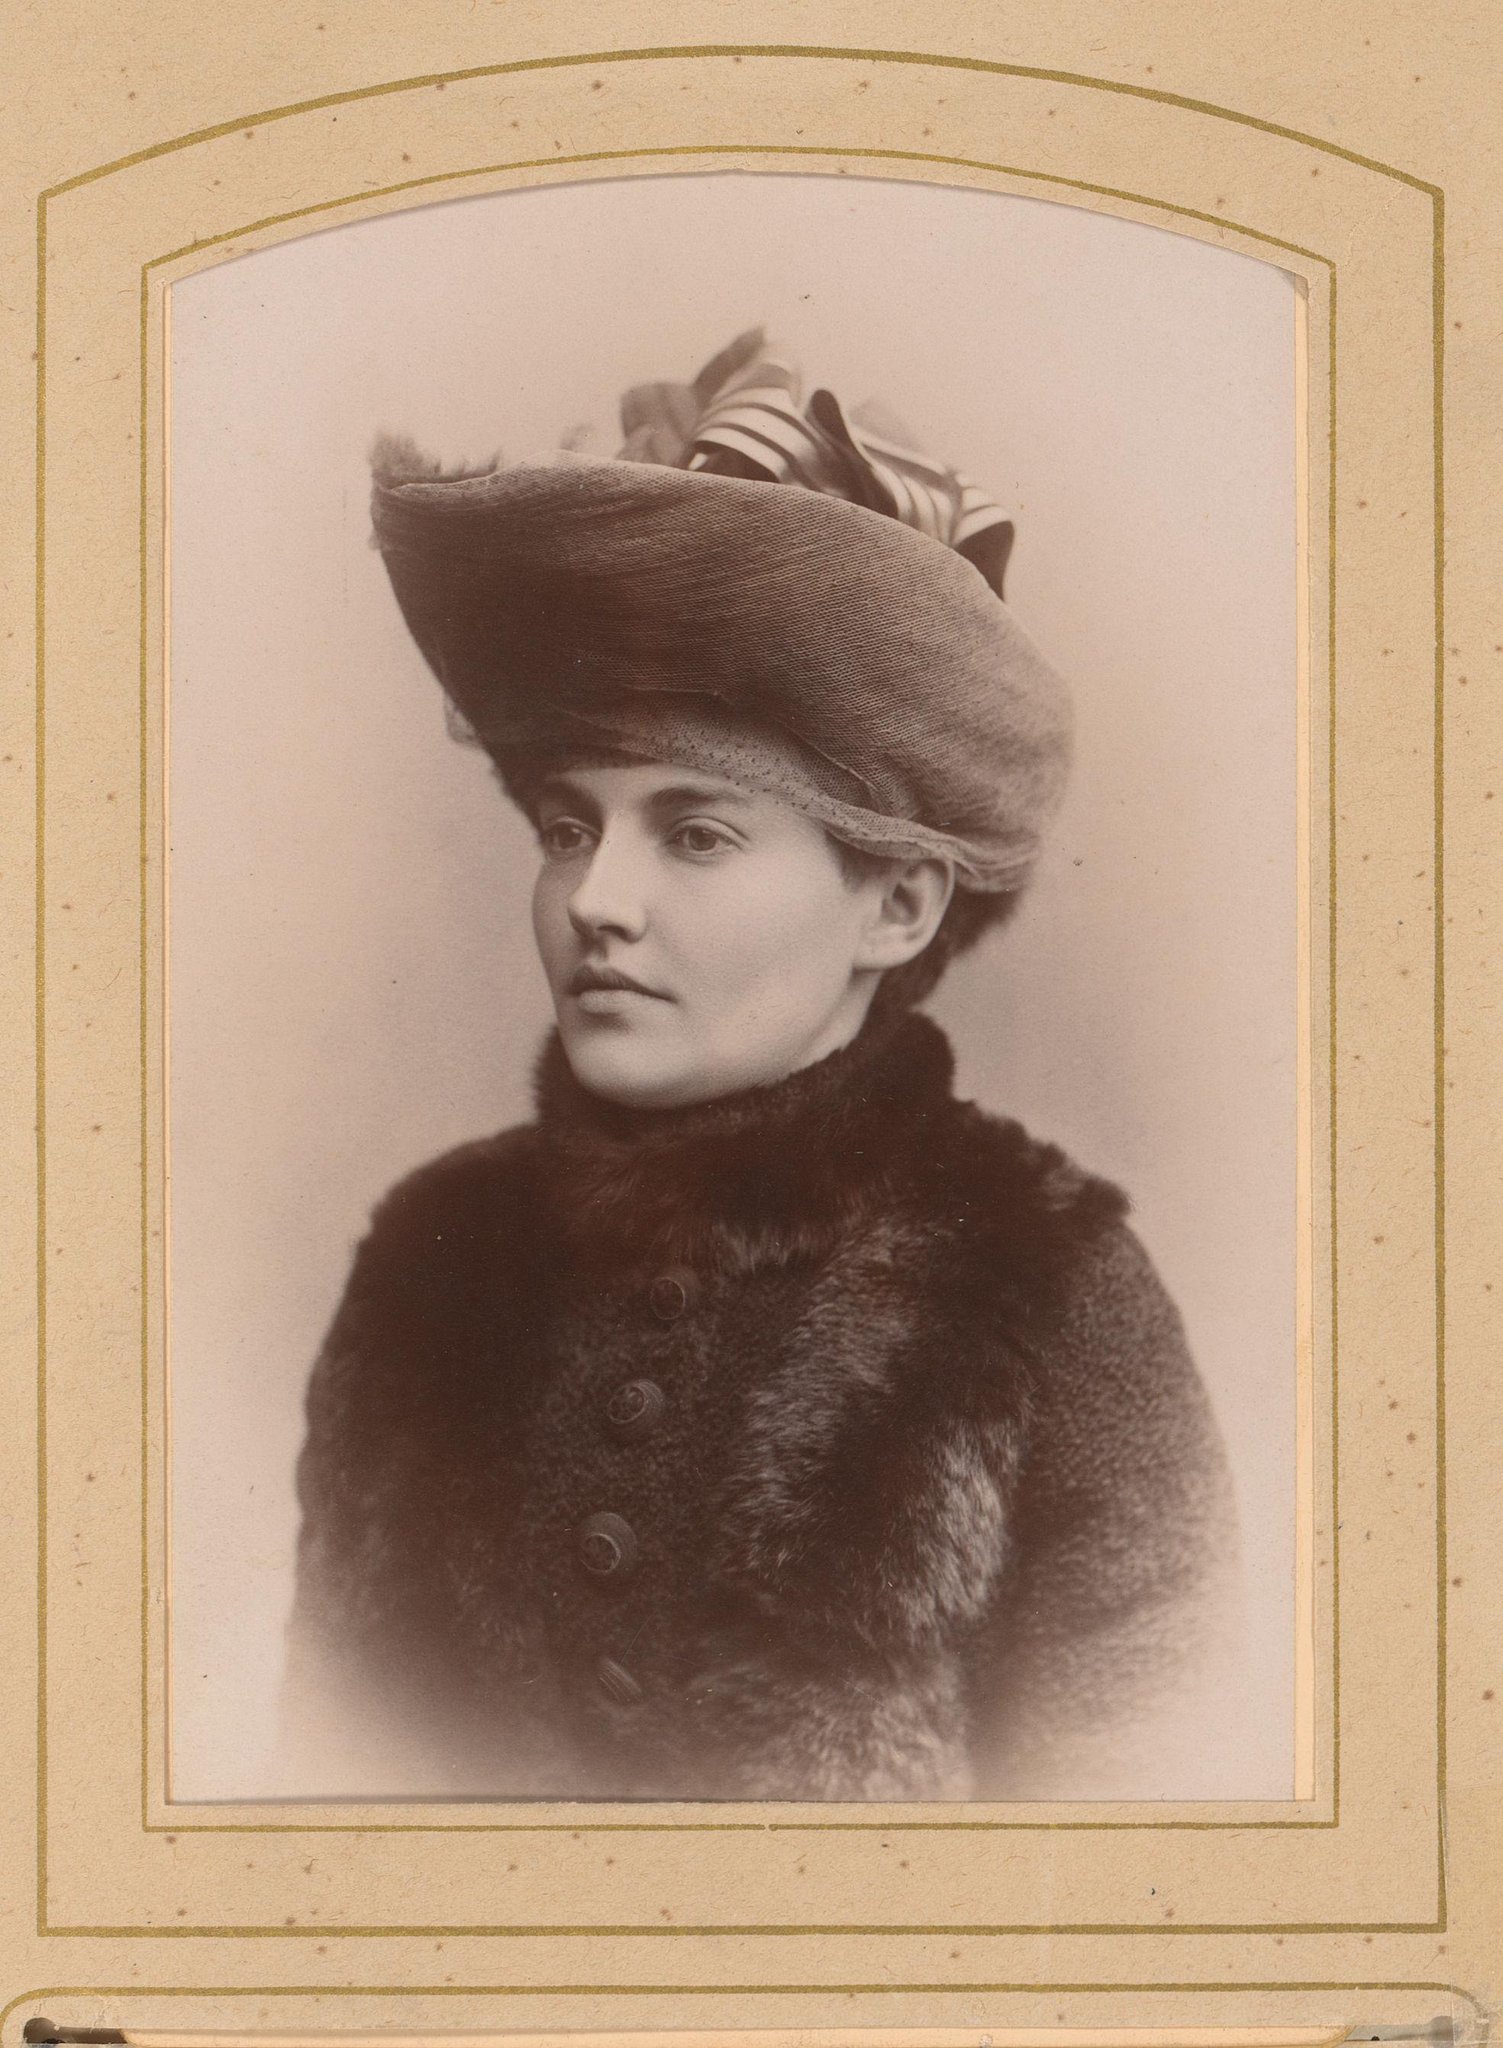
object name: album leaf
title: Portret van een vrouw in bontjas met hoed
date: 1860-1900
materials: cardboard, photographic support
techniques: albumen print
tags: historical persons - bb - woman, coat (+ fur used for clothes), coat: overcoat, head-gear: hat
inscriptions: inscription: ‘Gössnitz/ s/A./ Ed. Naumann/ Meerane/ i/S.’